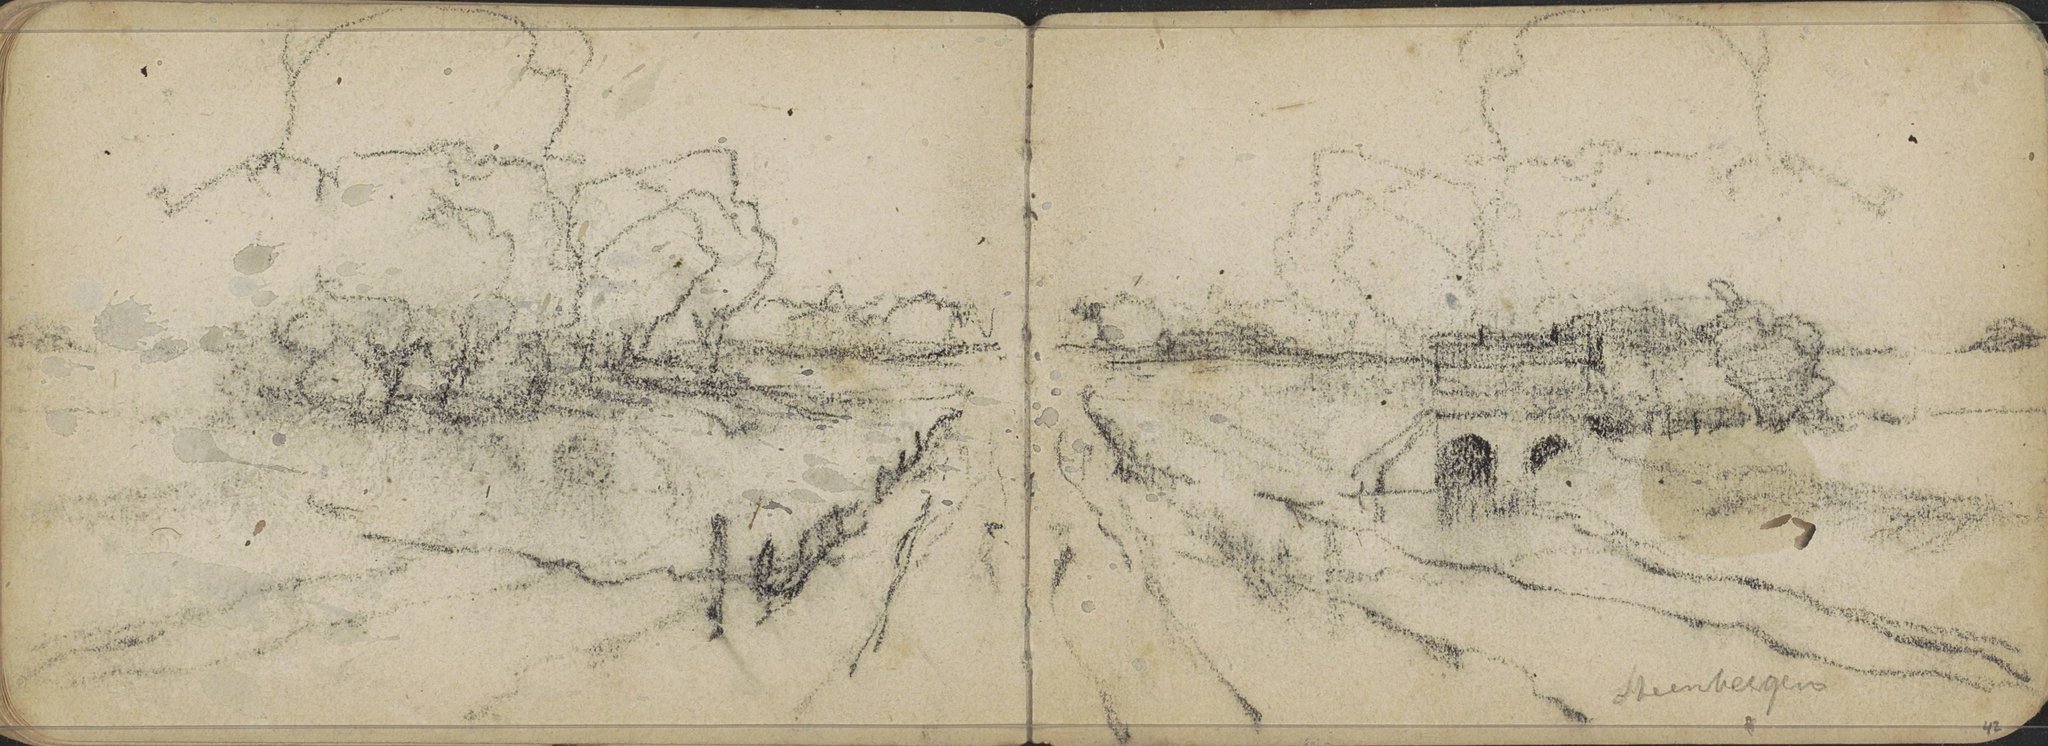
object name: sketchbook leaf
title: Brug bij Steenbergen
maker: willem cornelis rip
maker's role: draughtsman, painter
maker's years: 1856-1922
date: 1896-1897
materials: chalk, paper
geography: steenbergen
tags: landscapes, bridge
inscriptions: annotation: ‘Steenbergen’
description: Blad 41 verso en 42 recto uit een schetsboek met 44 bladen.